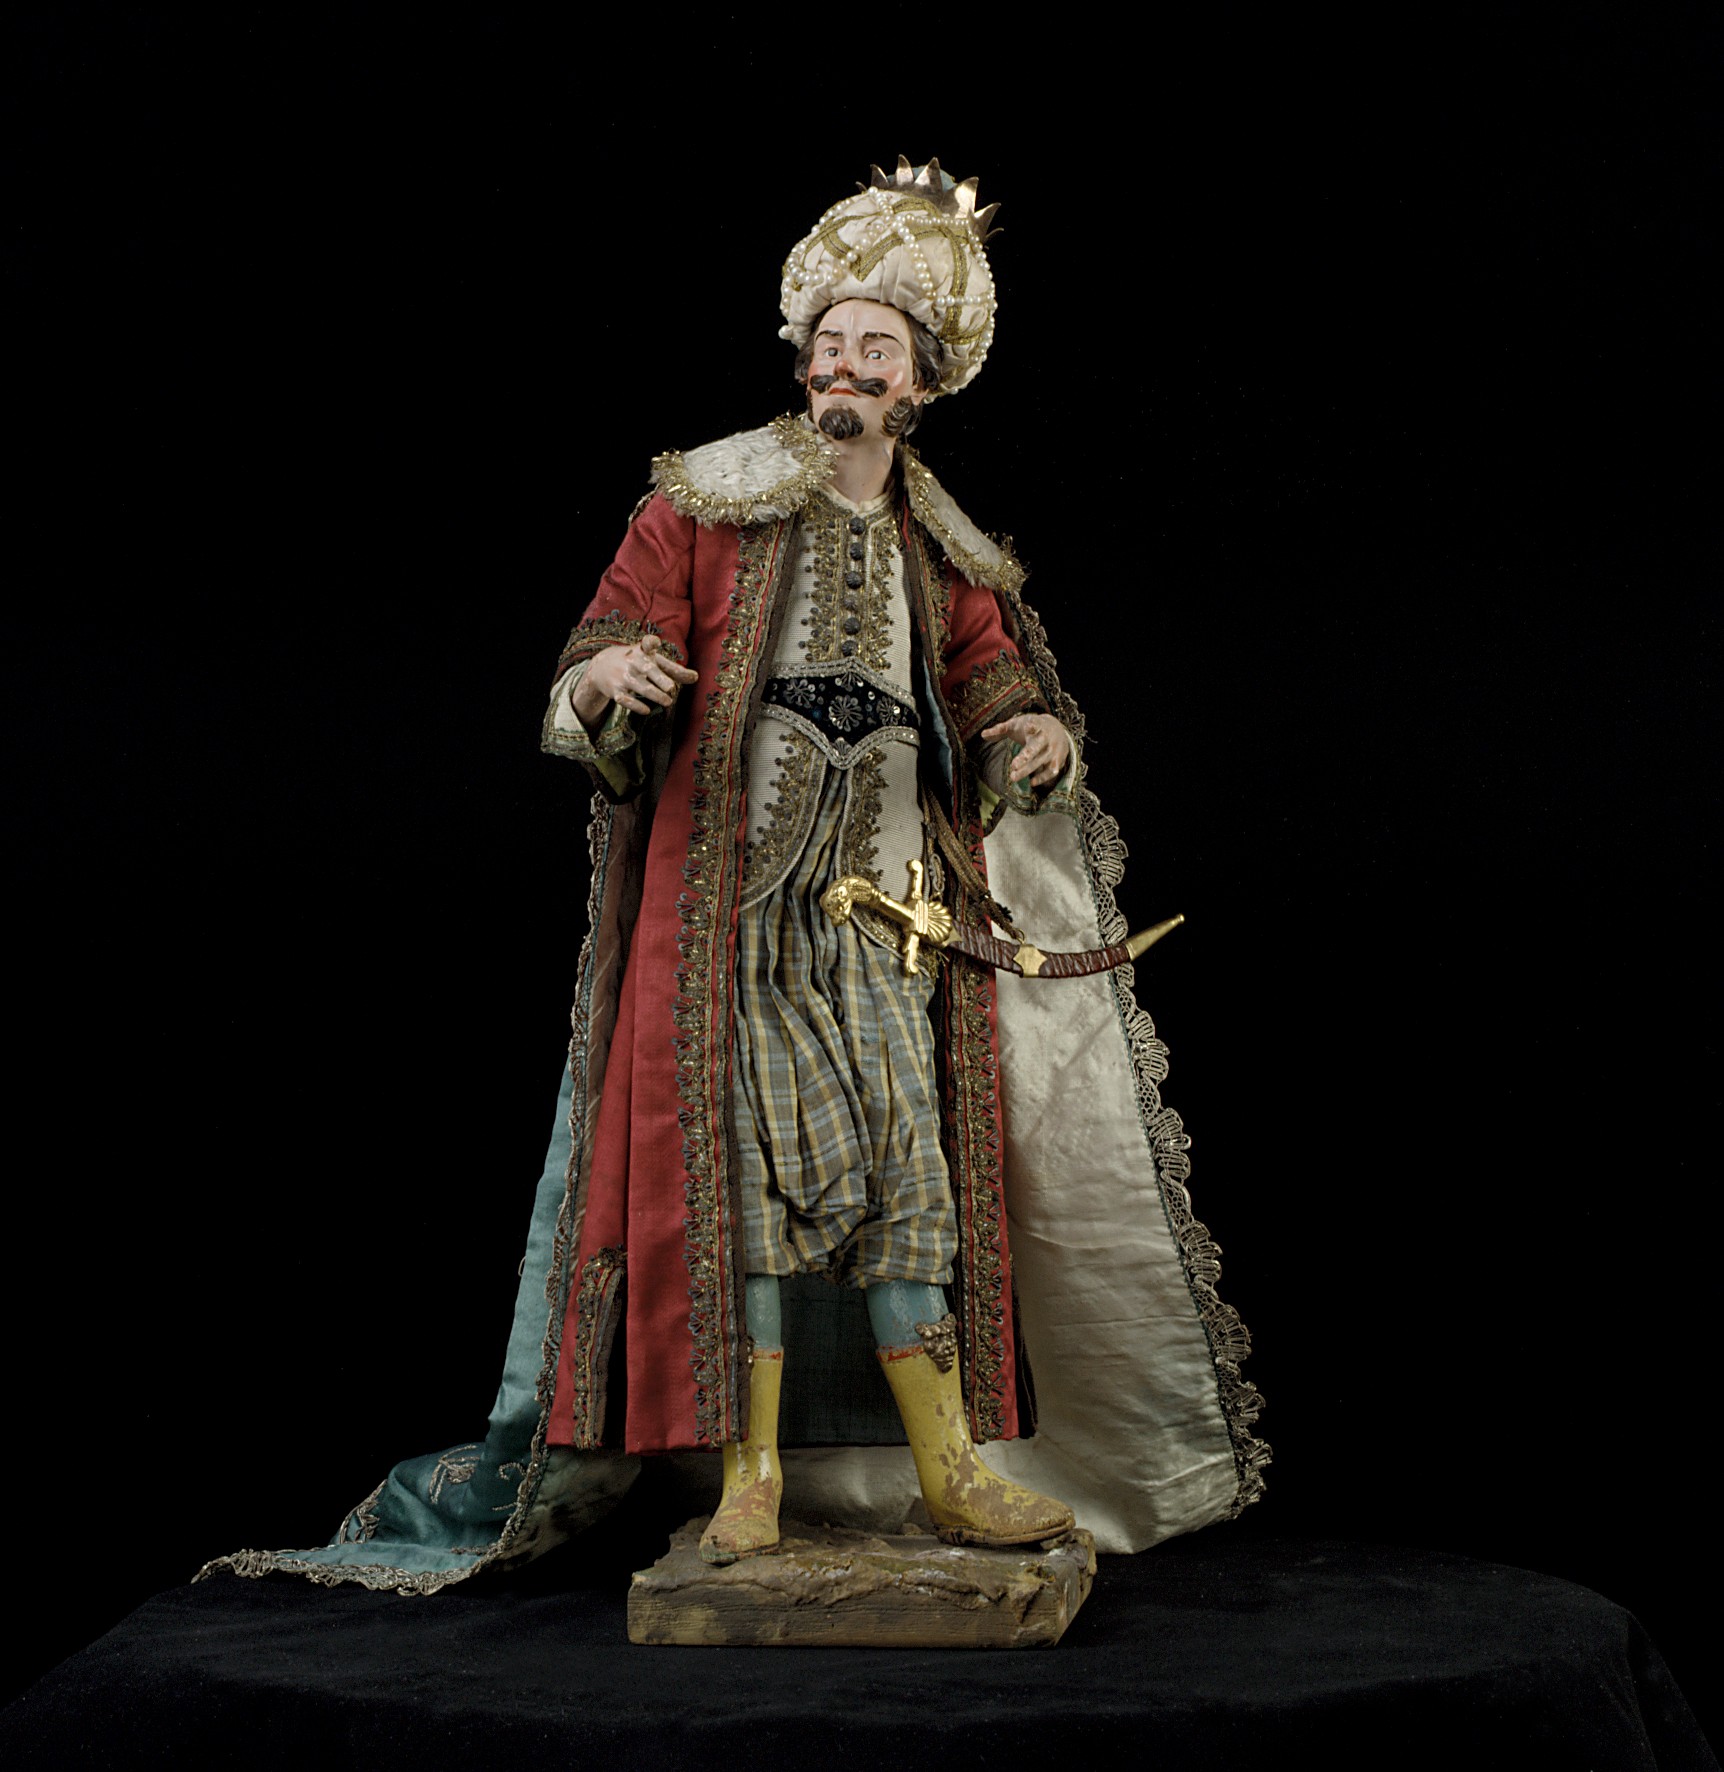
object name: crèche figure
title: King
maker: nicola ingaldi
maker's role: maker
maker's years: 1785-1815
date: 1751-1800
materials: leather, metal thread, textile, silk, silver, silver gilt, terracotta, fiber, velvet, metal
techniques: polychrome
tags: swords,kings